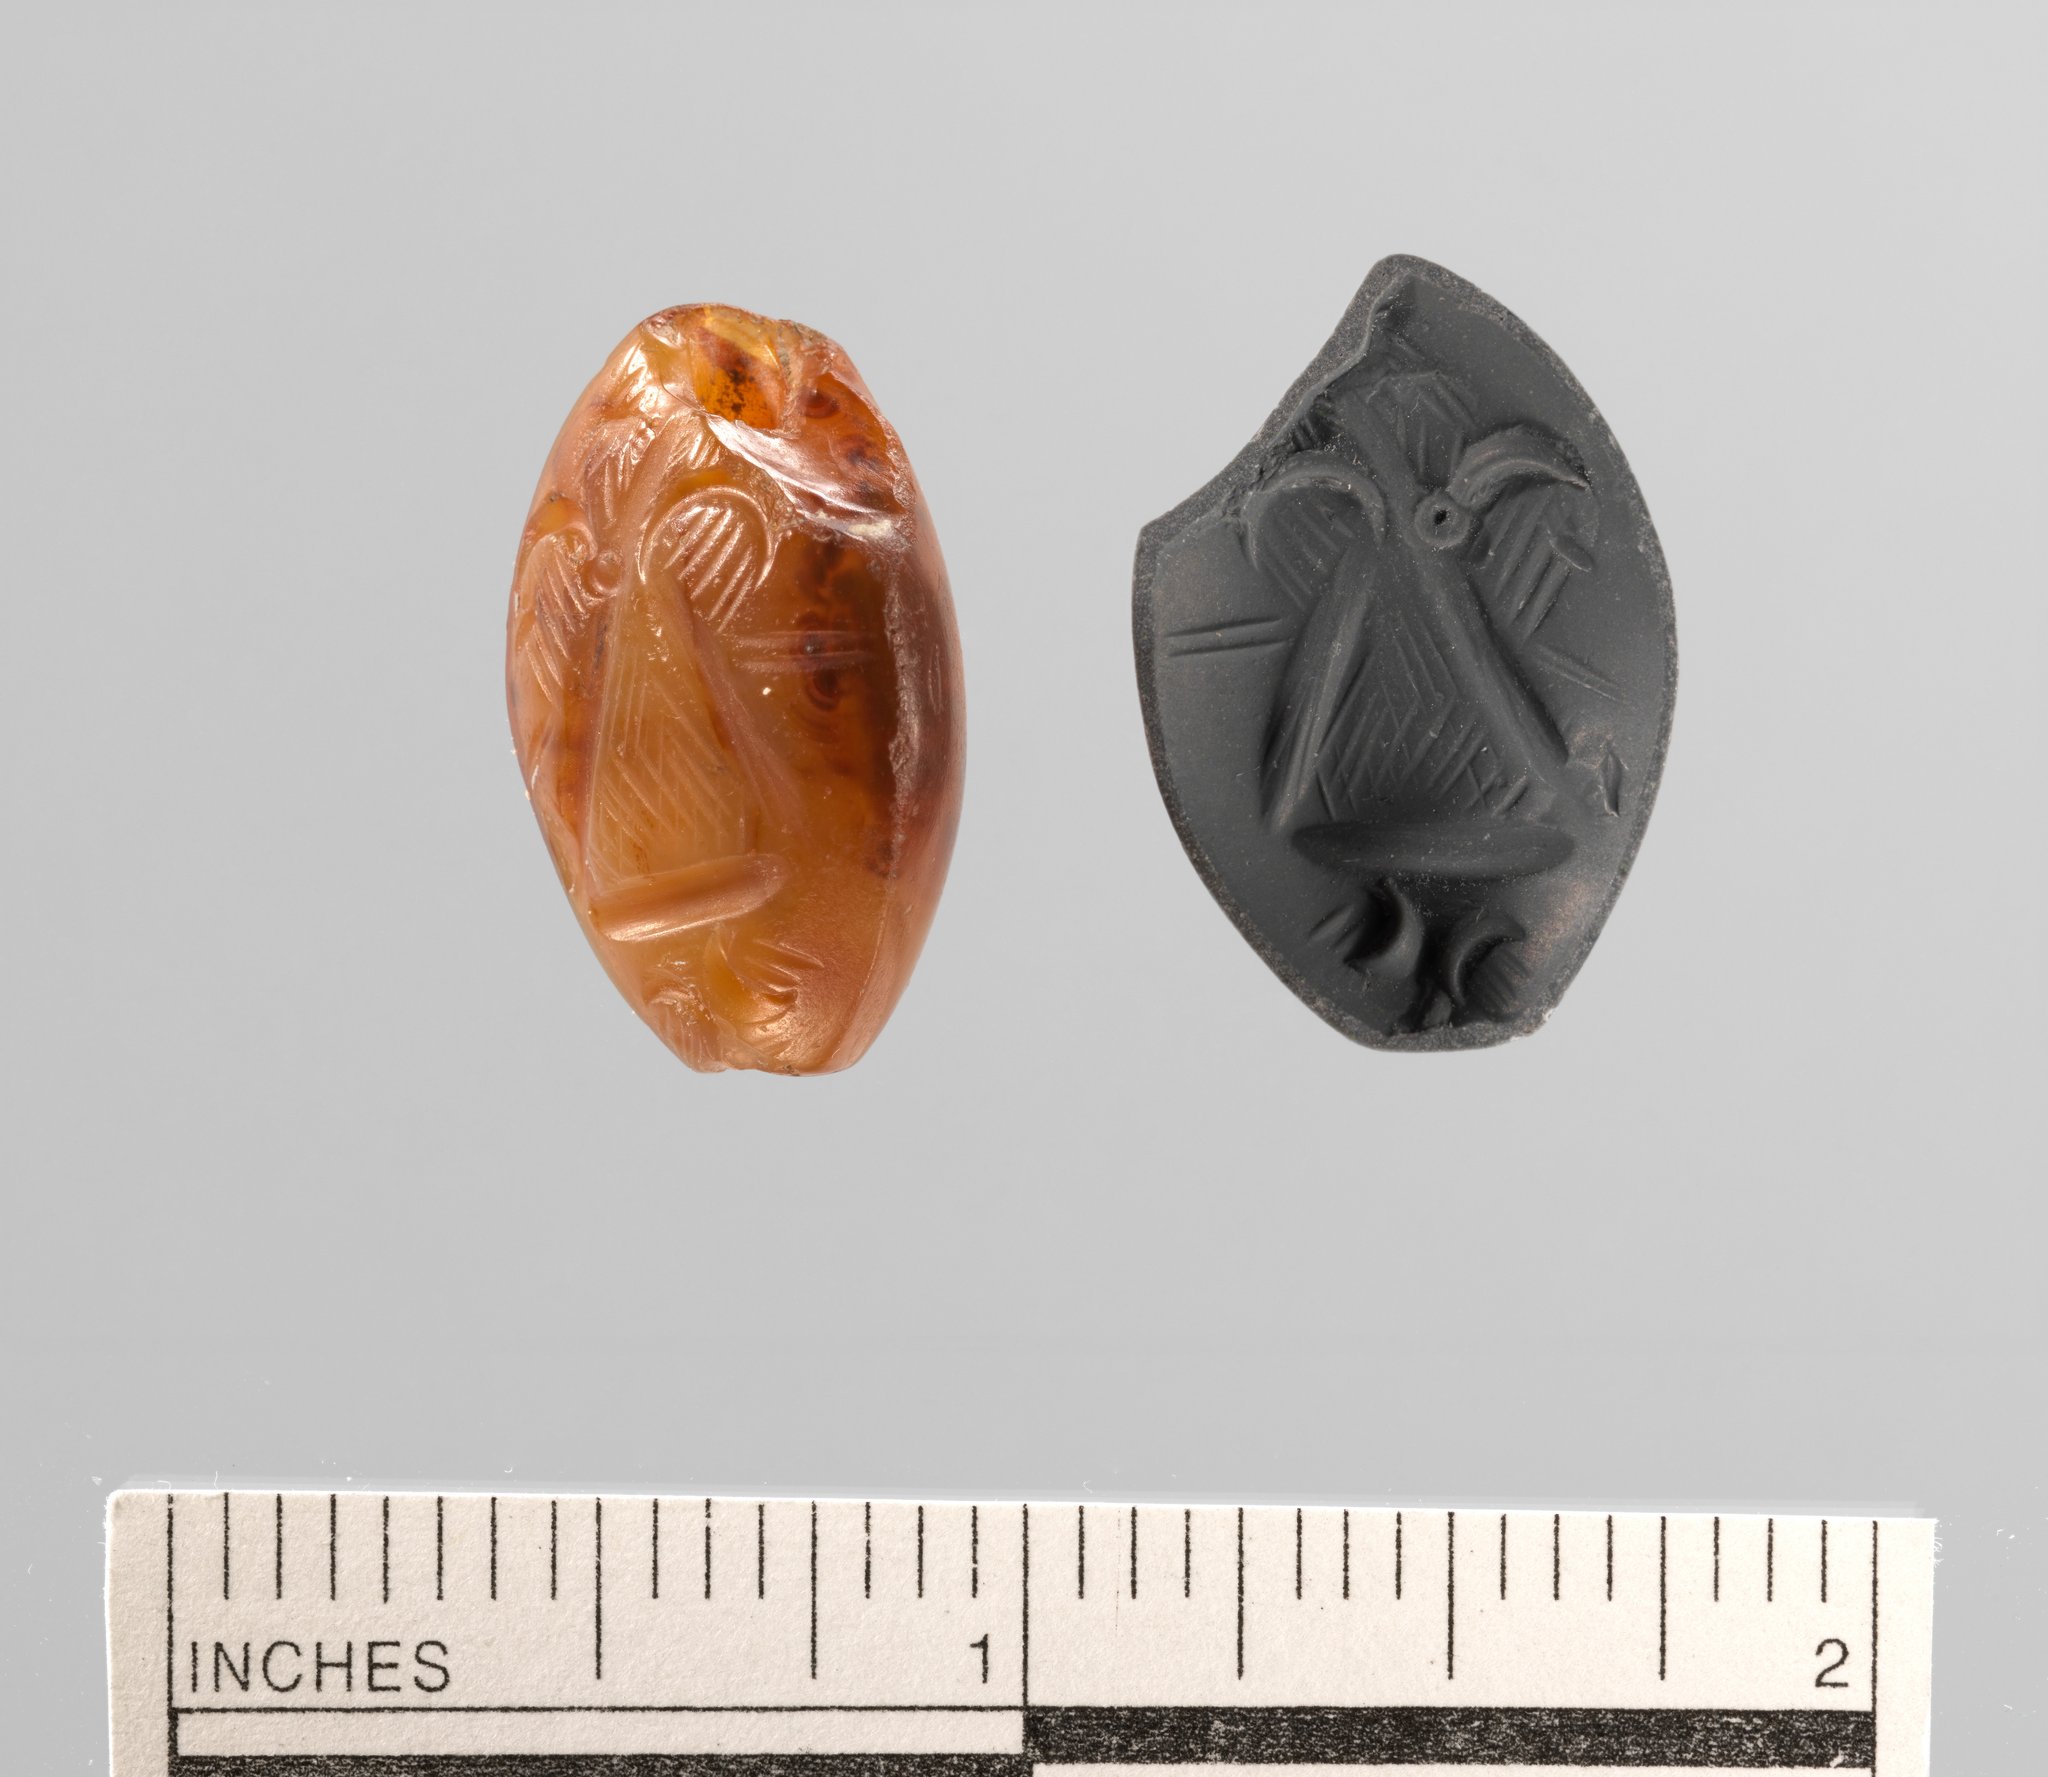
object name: seal, carinated amygdaloid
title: Carnelian Carinated Amygdaloid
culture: minoan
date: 1650-1500 BCE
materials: gemstone